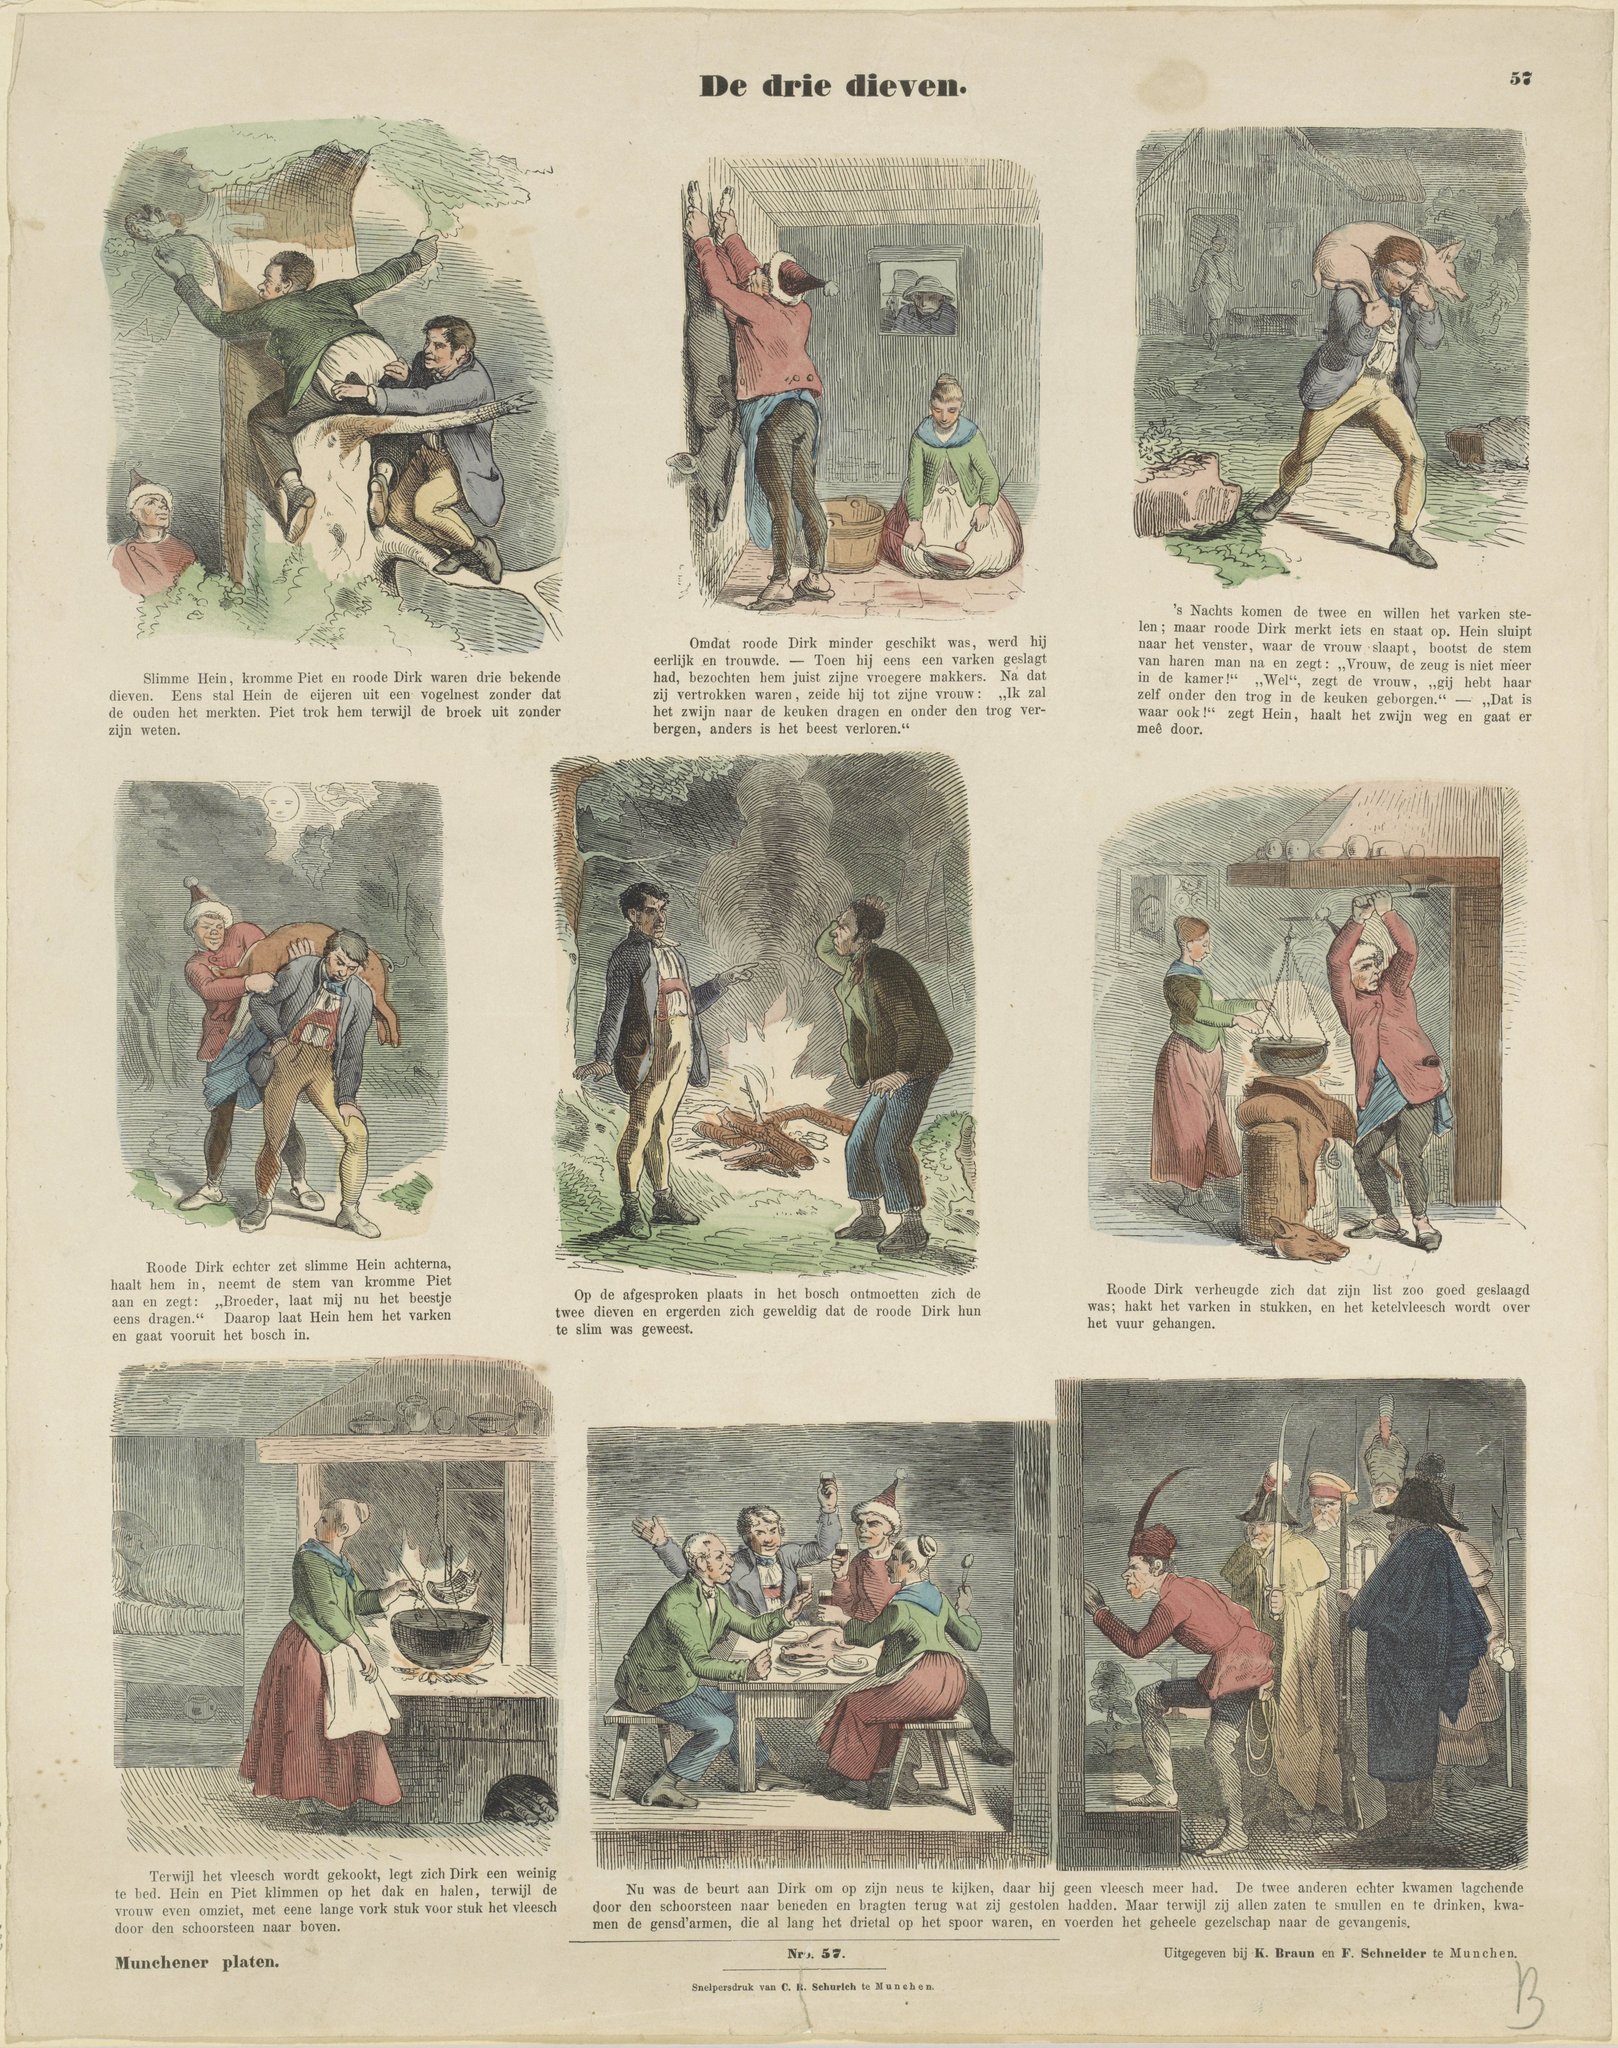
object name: print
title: De drie dieven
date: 1843-1920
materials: paper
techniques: colour, letterpress printing, engraving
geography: germany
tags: thief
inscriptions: collector's mark: Lugt 2760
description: Blad met 7 voorstellingen uit het verhaal van de drie dieven en hoe zij uiteindelijk in de gevangenis belanden. Onder elke afbeelding een onderschrift. Genummerd midden onder: Nro. 57. Genummerd rechtsboven: 57.